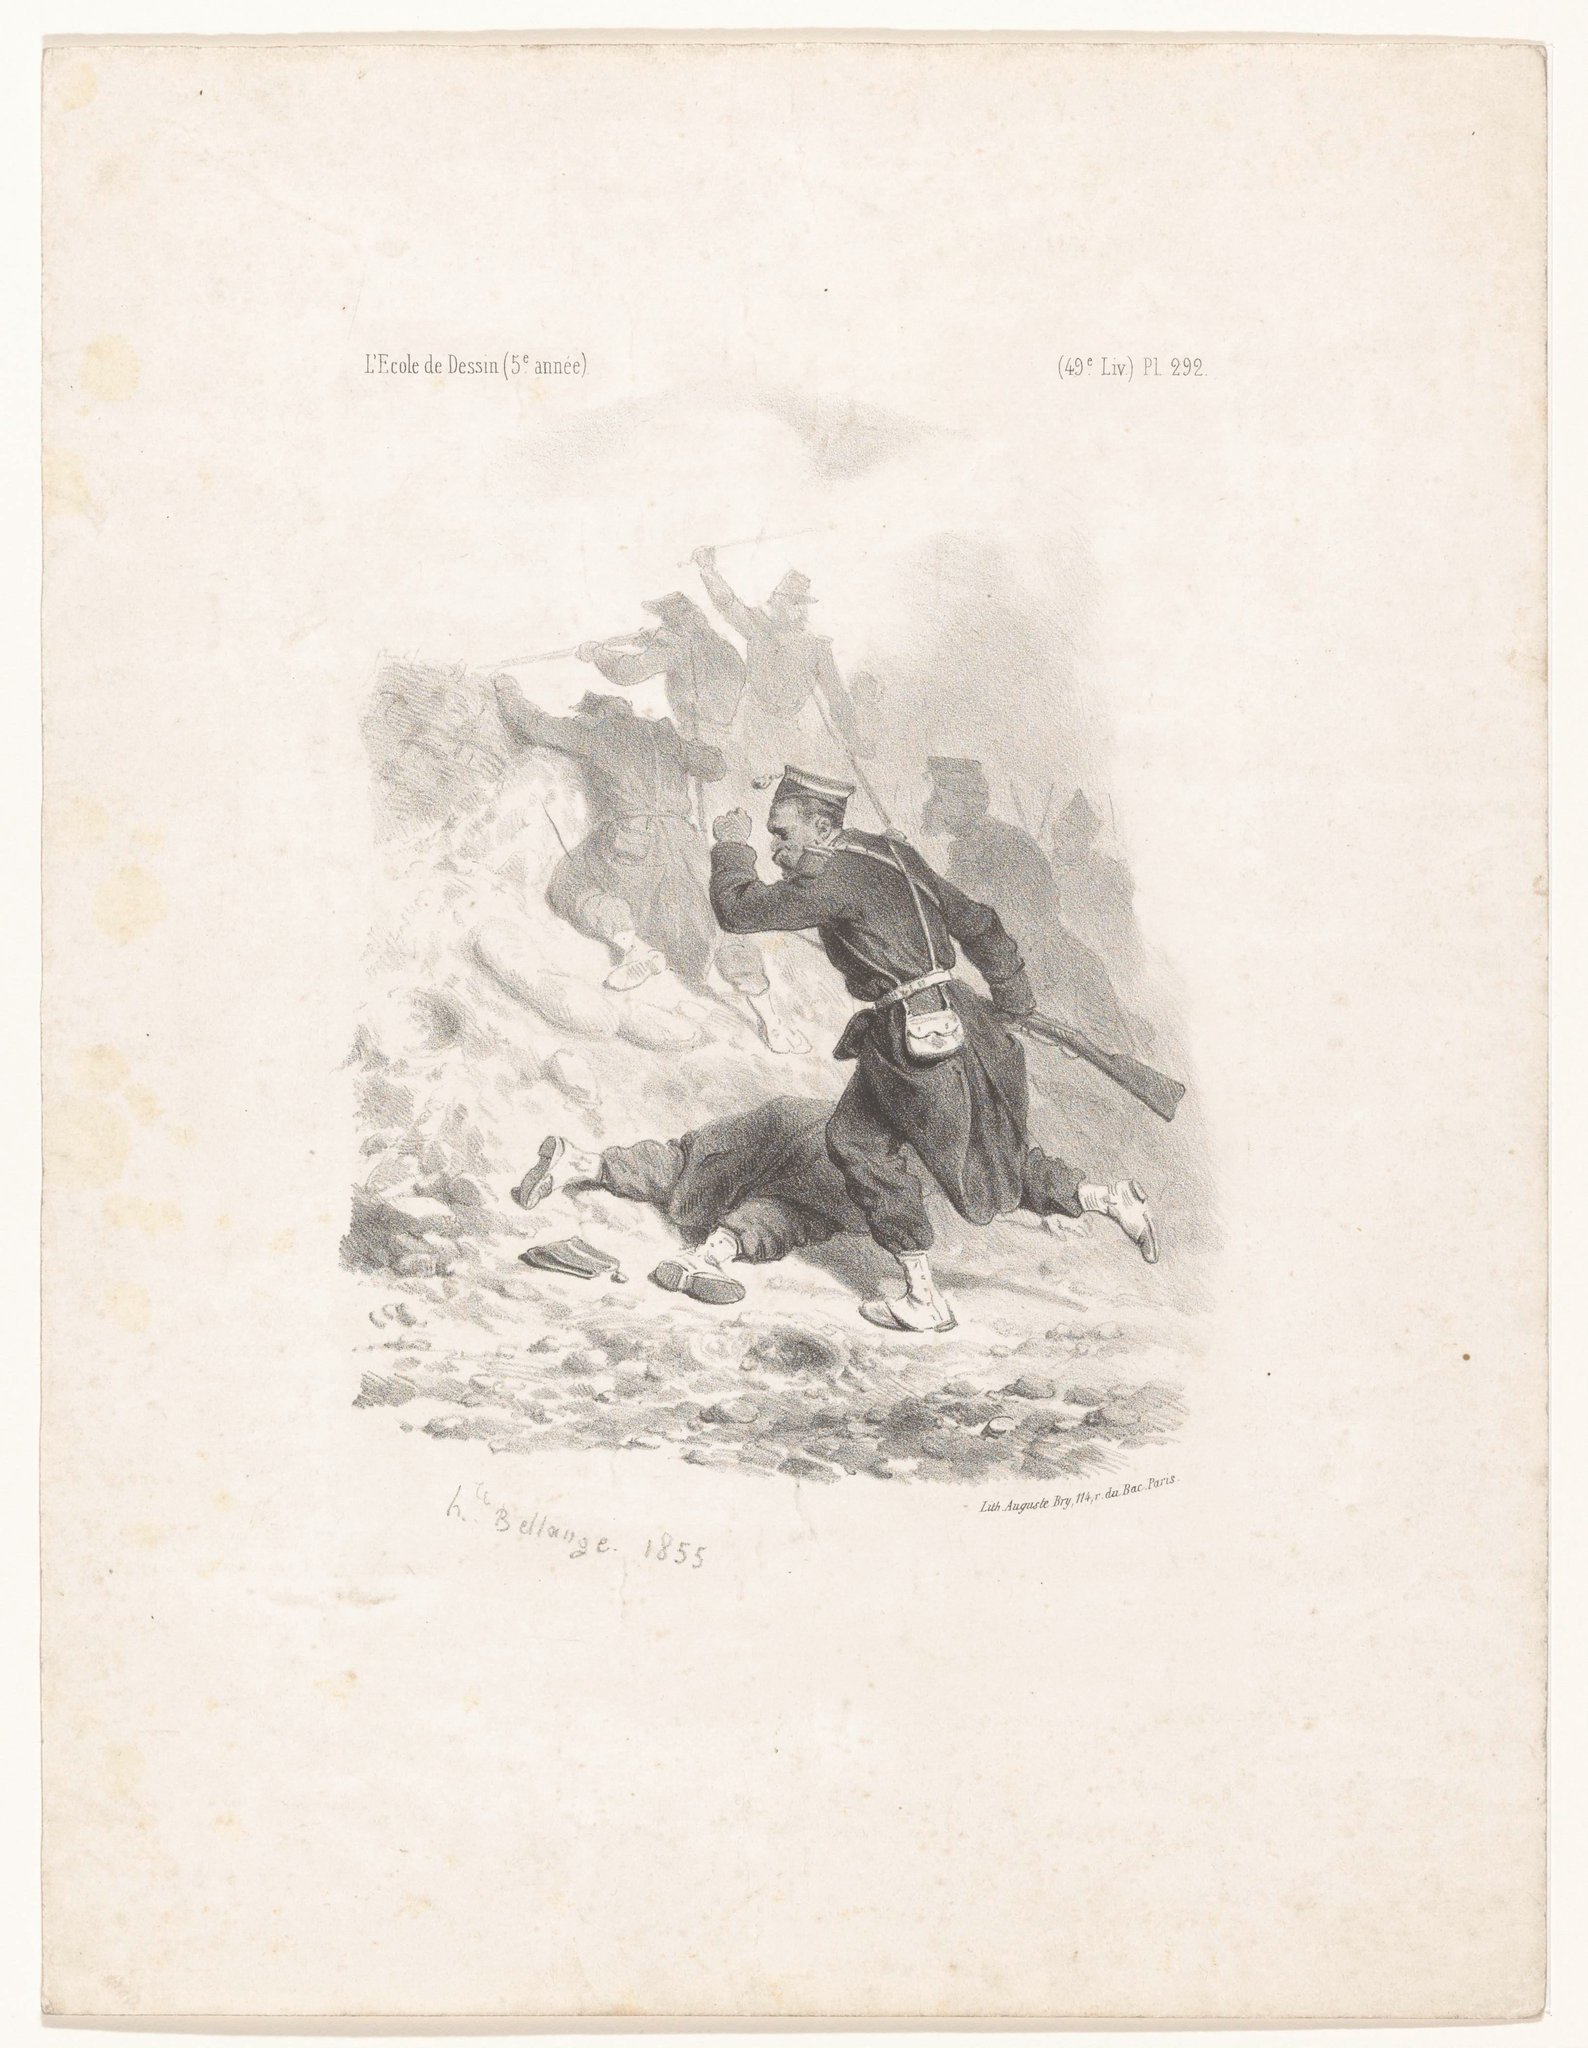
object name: book illustration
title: Tekenschool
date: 1855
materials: paper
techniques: lithograph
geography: paris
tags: trenches (+ handling of weapons), battle, fighting in general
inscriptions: collector's mark: Lugt 2228a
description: Gepubliceerd in: L'École de dessin, nr. 49.